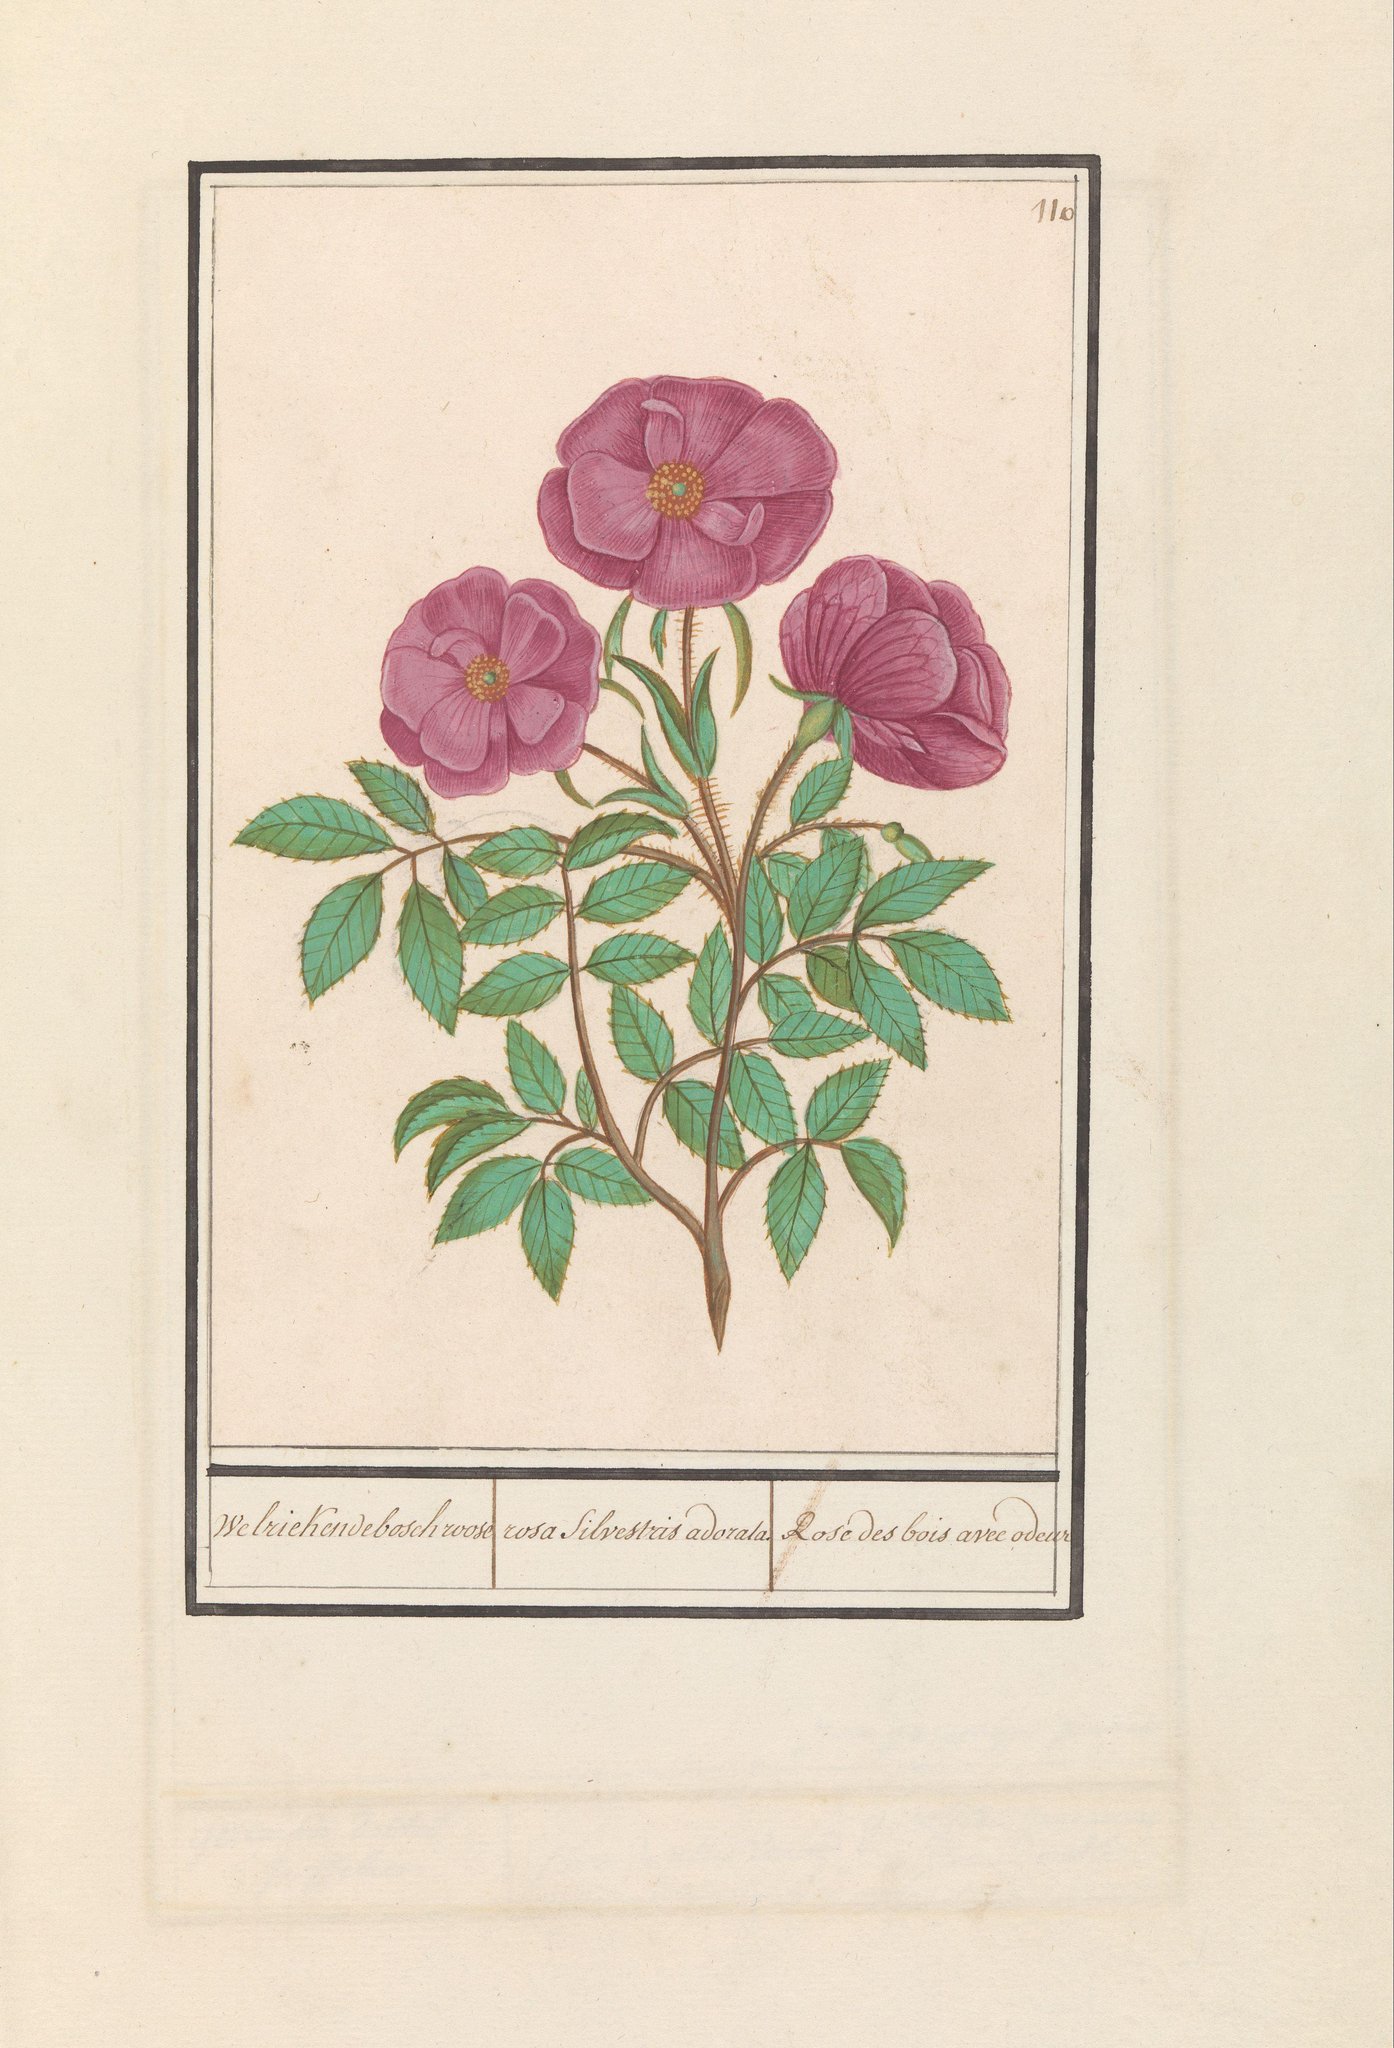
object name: drawing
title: Welriekende bosch roose / rosa silverstris adorata. / Rose des bois avec odeur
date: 1596-1610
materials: paint, paper, pencil, watercolor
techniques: brush, pen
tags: flowers: rose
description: Wilde welriekende roos. Rechtsboven genummerd: 110. Onderdeel van het tweede album met tekeningen van bloemen en planten. Negende van twaalf albums met tekeningen van dieren, vogels en planten bekend rond 1600, gemaakt in opdracht van keizer Rudolf II. Met toelichting in Nederlands, Latijn en Frans.